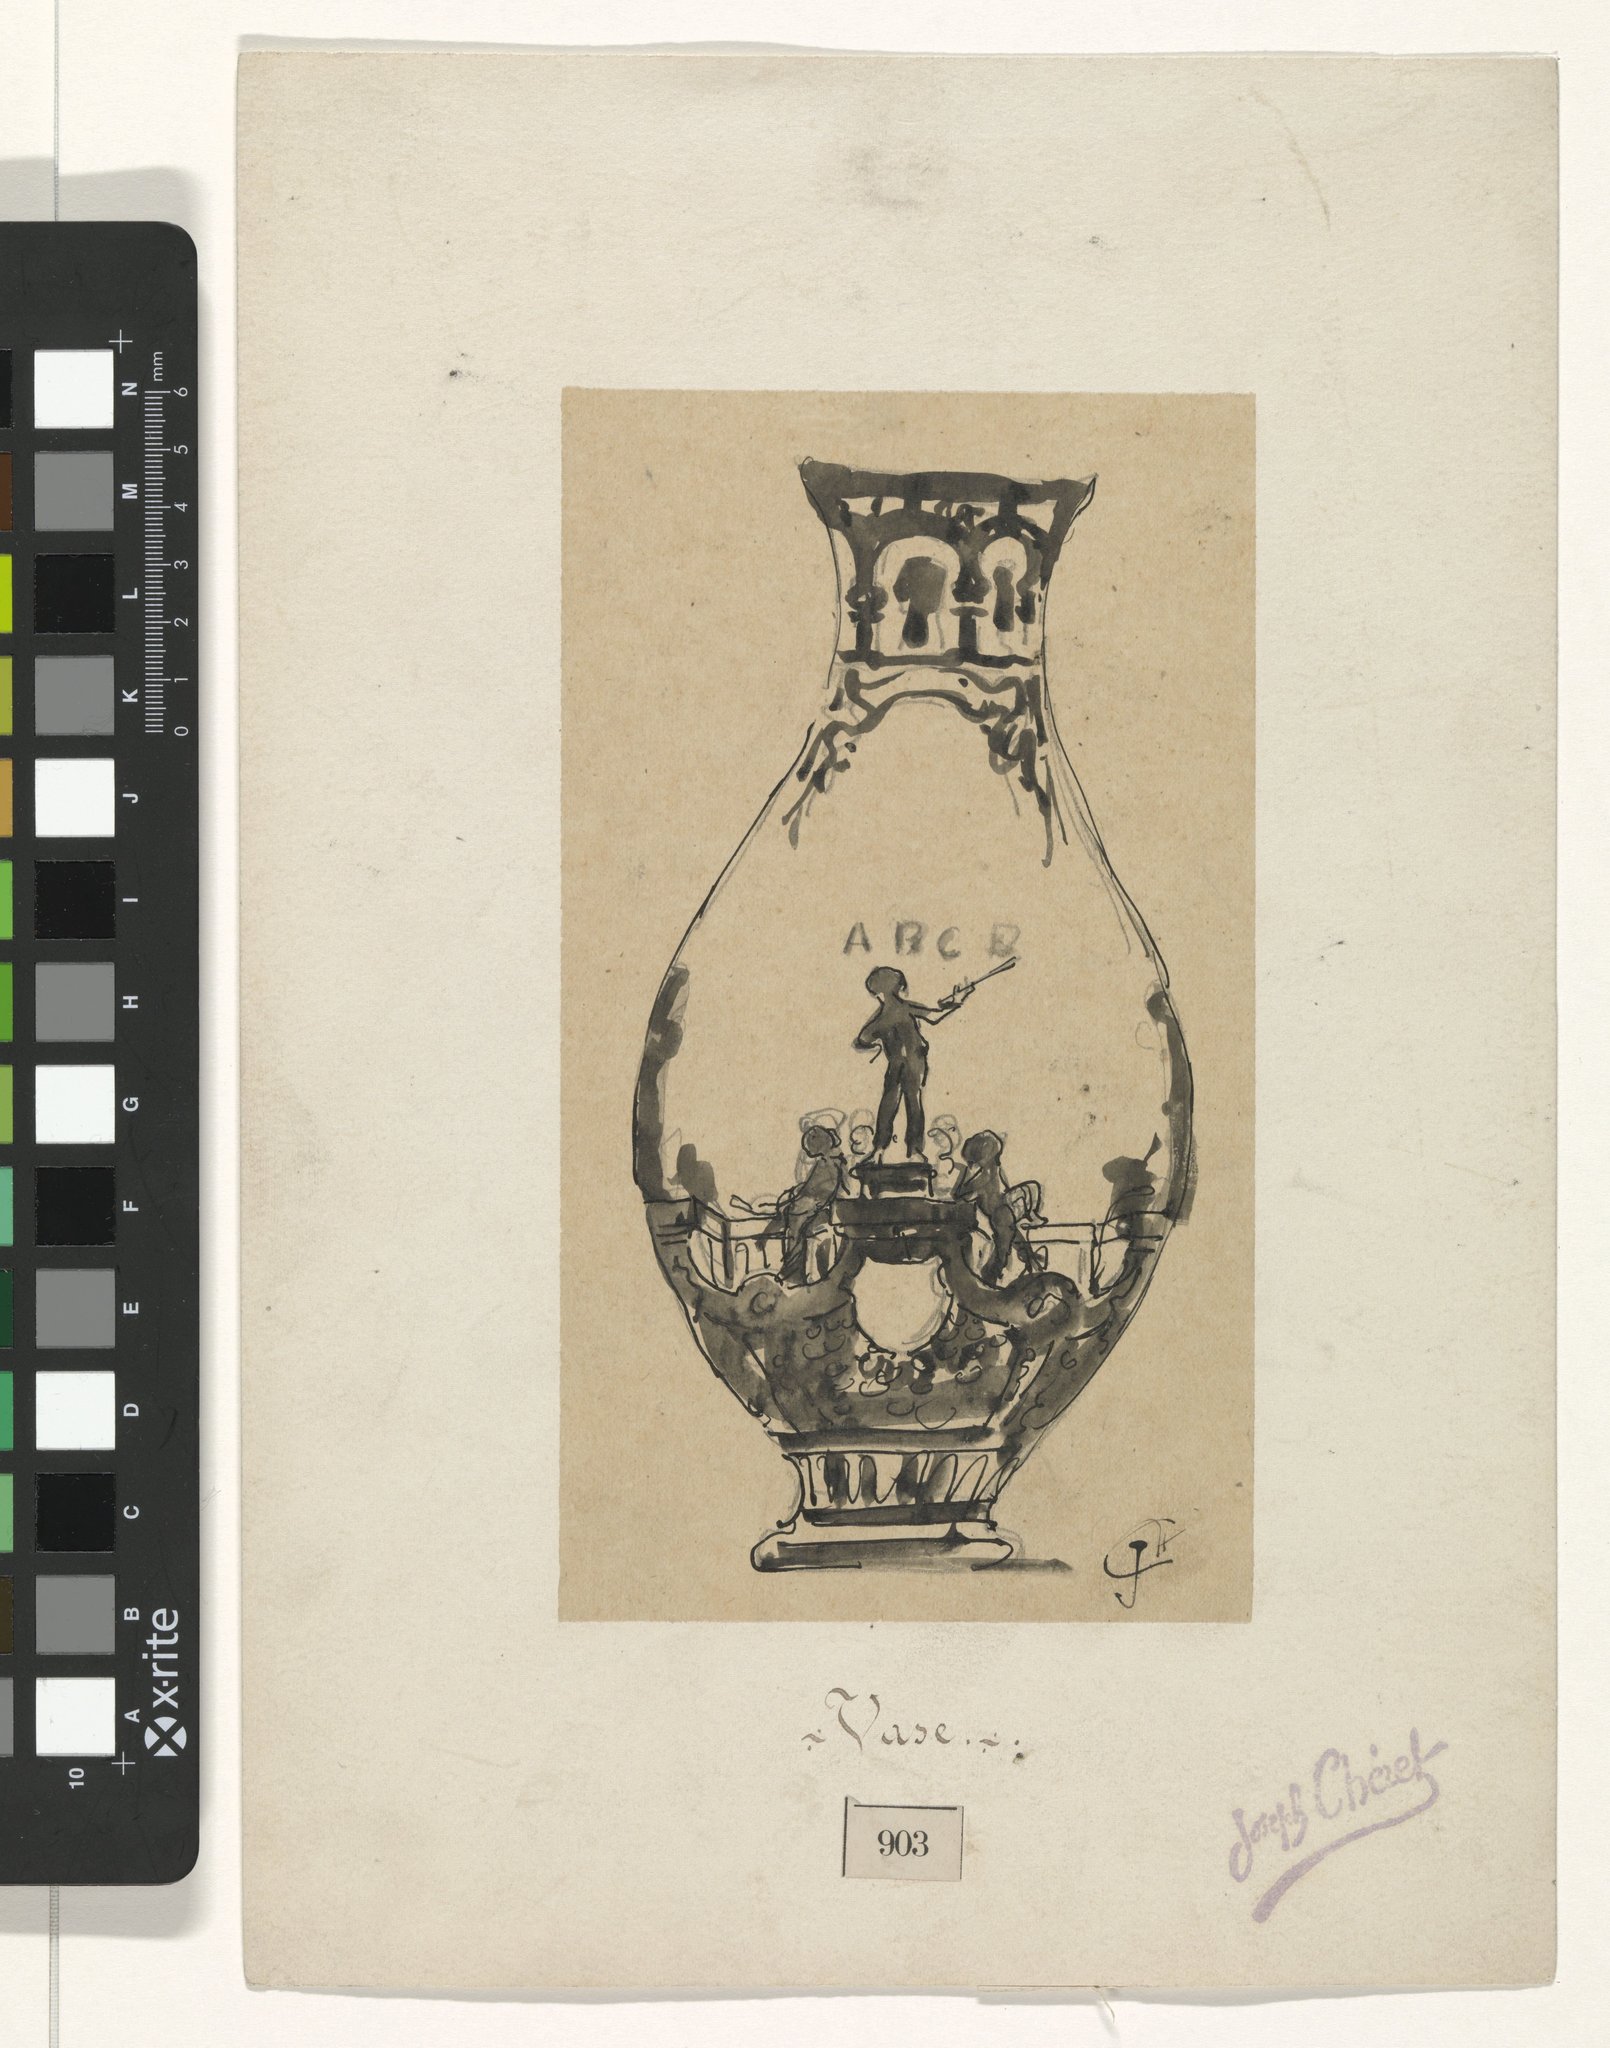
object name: design drawing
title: Vaas met figuren waarvan er een de letters ABCD schildert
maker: gustave joseph chéret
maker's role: sculptor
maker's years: 1838-1894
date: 1870-1894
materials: cardboard, graphite, paper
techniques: brush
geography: paris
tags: containers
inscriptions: monogram: ‘JC’, workshop stamp: ‘Joseph Chéret’, inscription: ‘Vase’, label: ‘903’, inscription: ‘500’